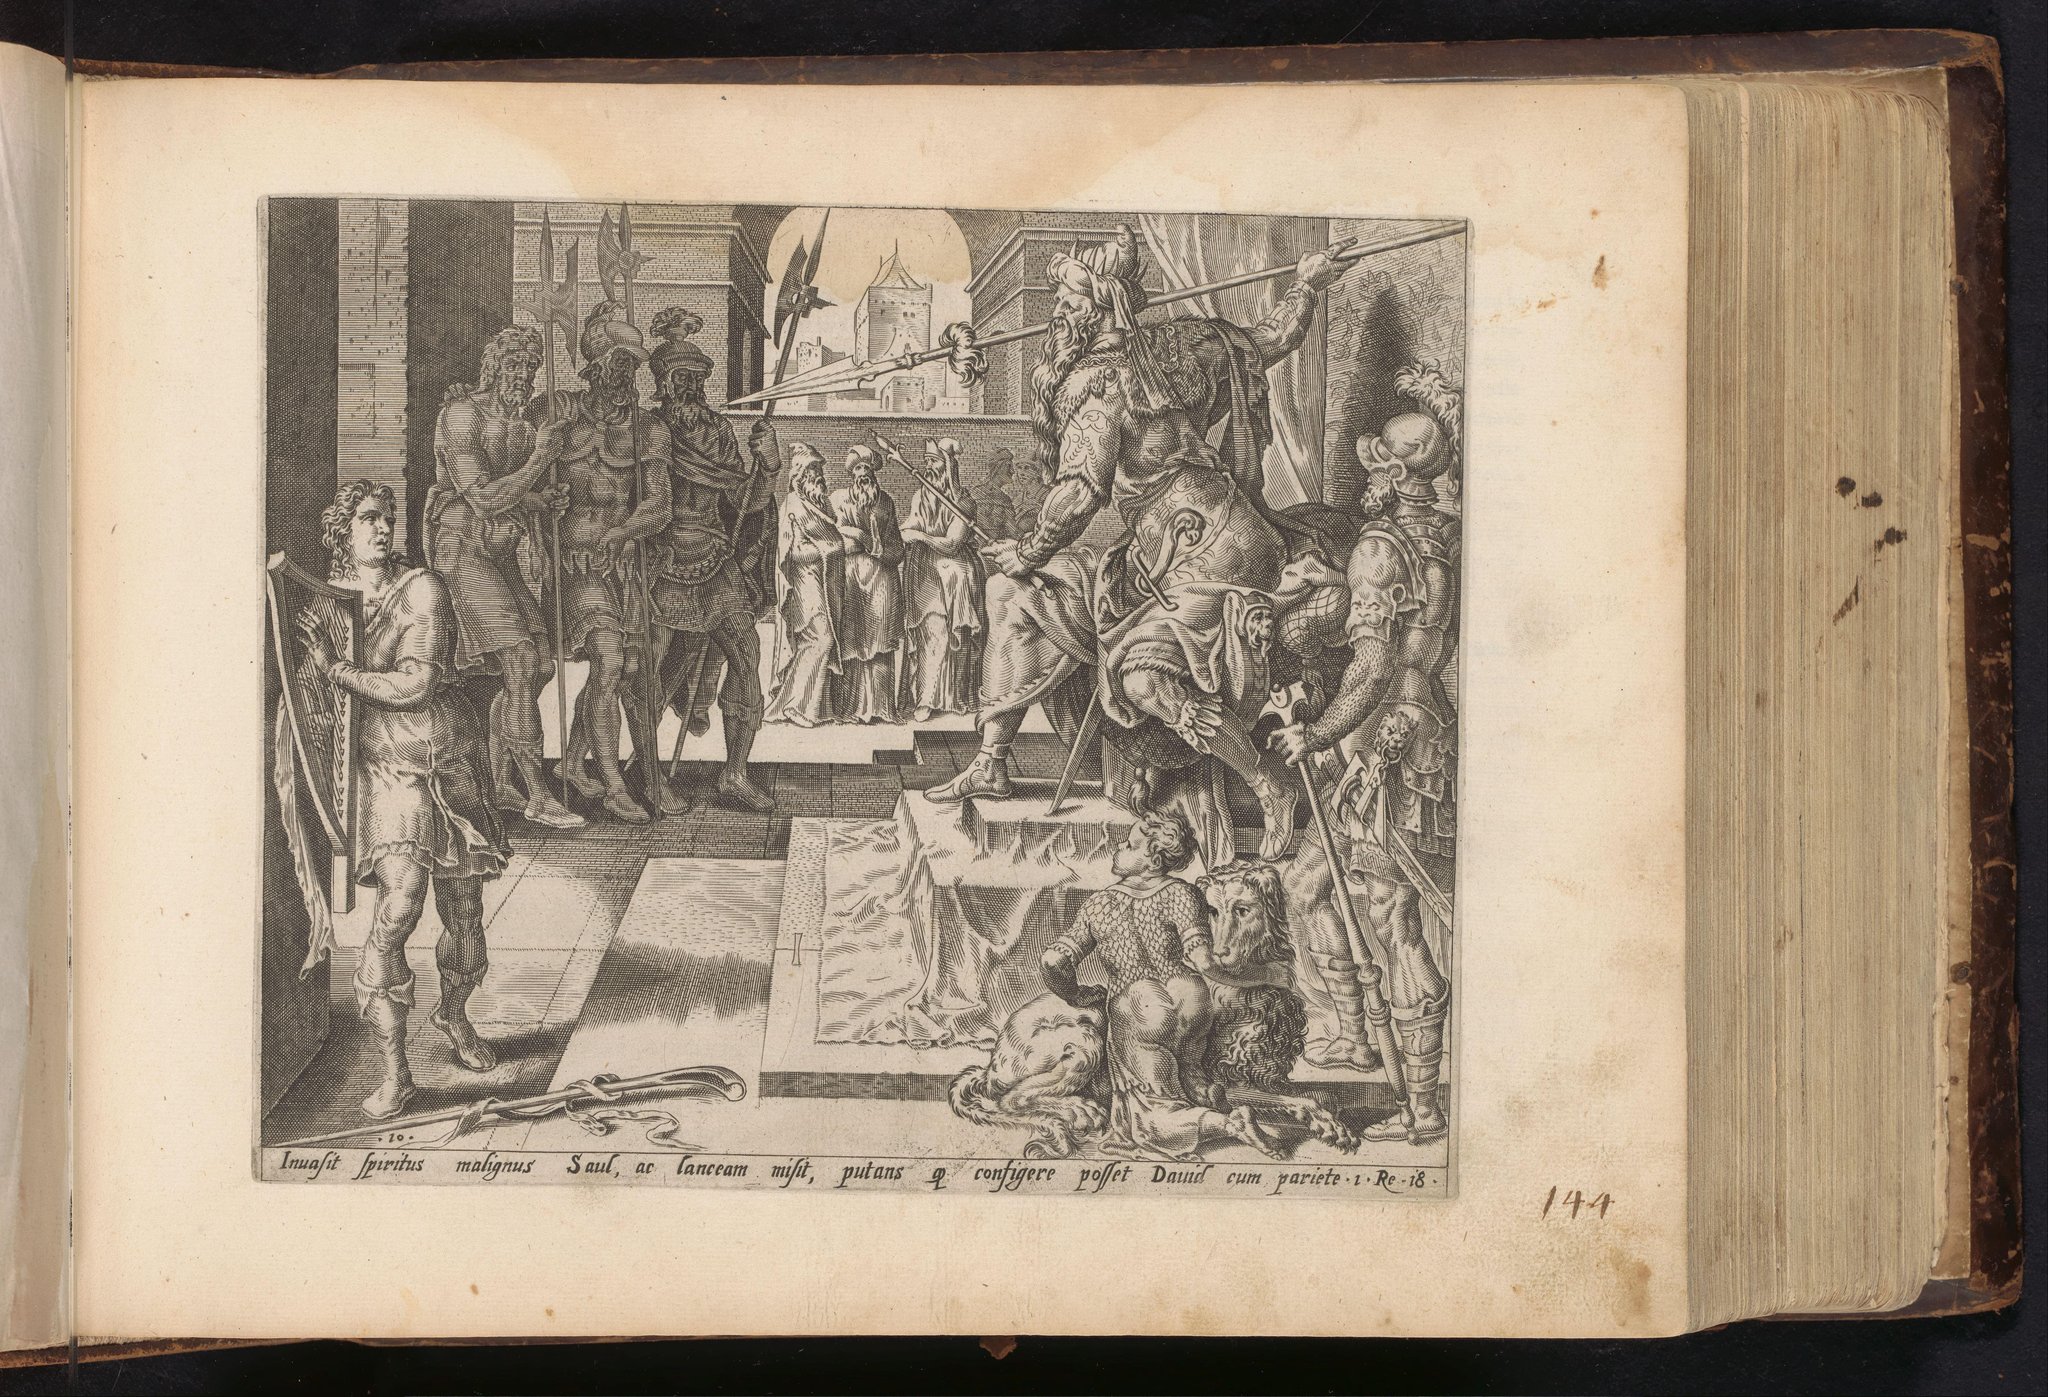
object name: print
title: Geschiedenis van David en Saul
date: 1554-1558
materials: paper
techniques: engraving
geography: alkmaar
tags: saul casts his spear at david when the latter is playing his harp before the king (1 samuel 18:11)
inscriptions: number: ‘144’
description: Saul wordt overmand door jaloezie en richt zijn speer op David, die voor hem zijn harp bespeelt. Enkele hovelingen en lijfwachten kijken toe. Onder de voorstelling een verwijzing in het Latijn naar de Bijbeltekst in 1 Sam. 18. Deze prent maakt deel uit van een album.